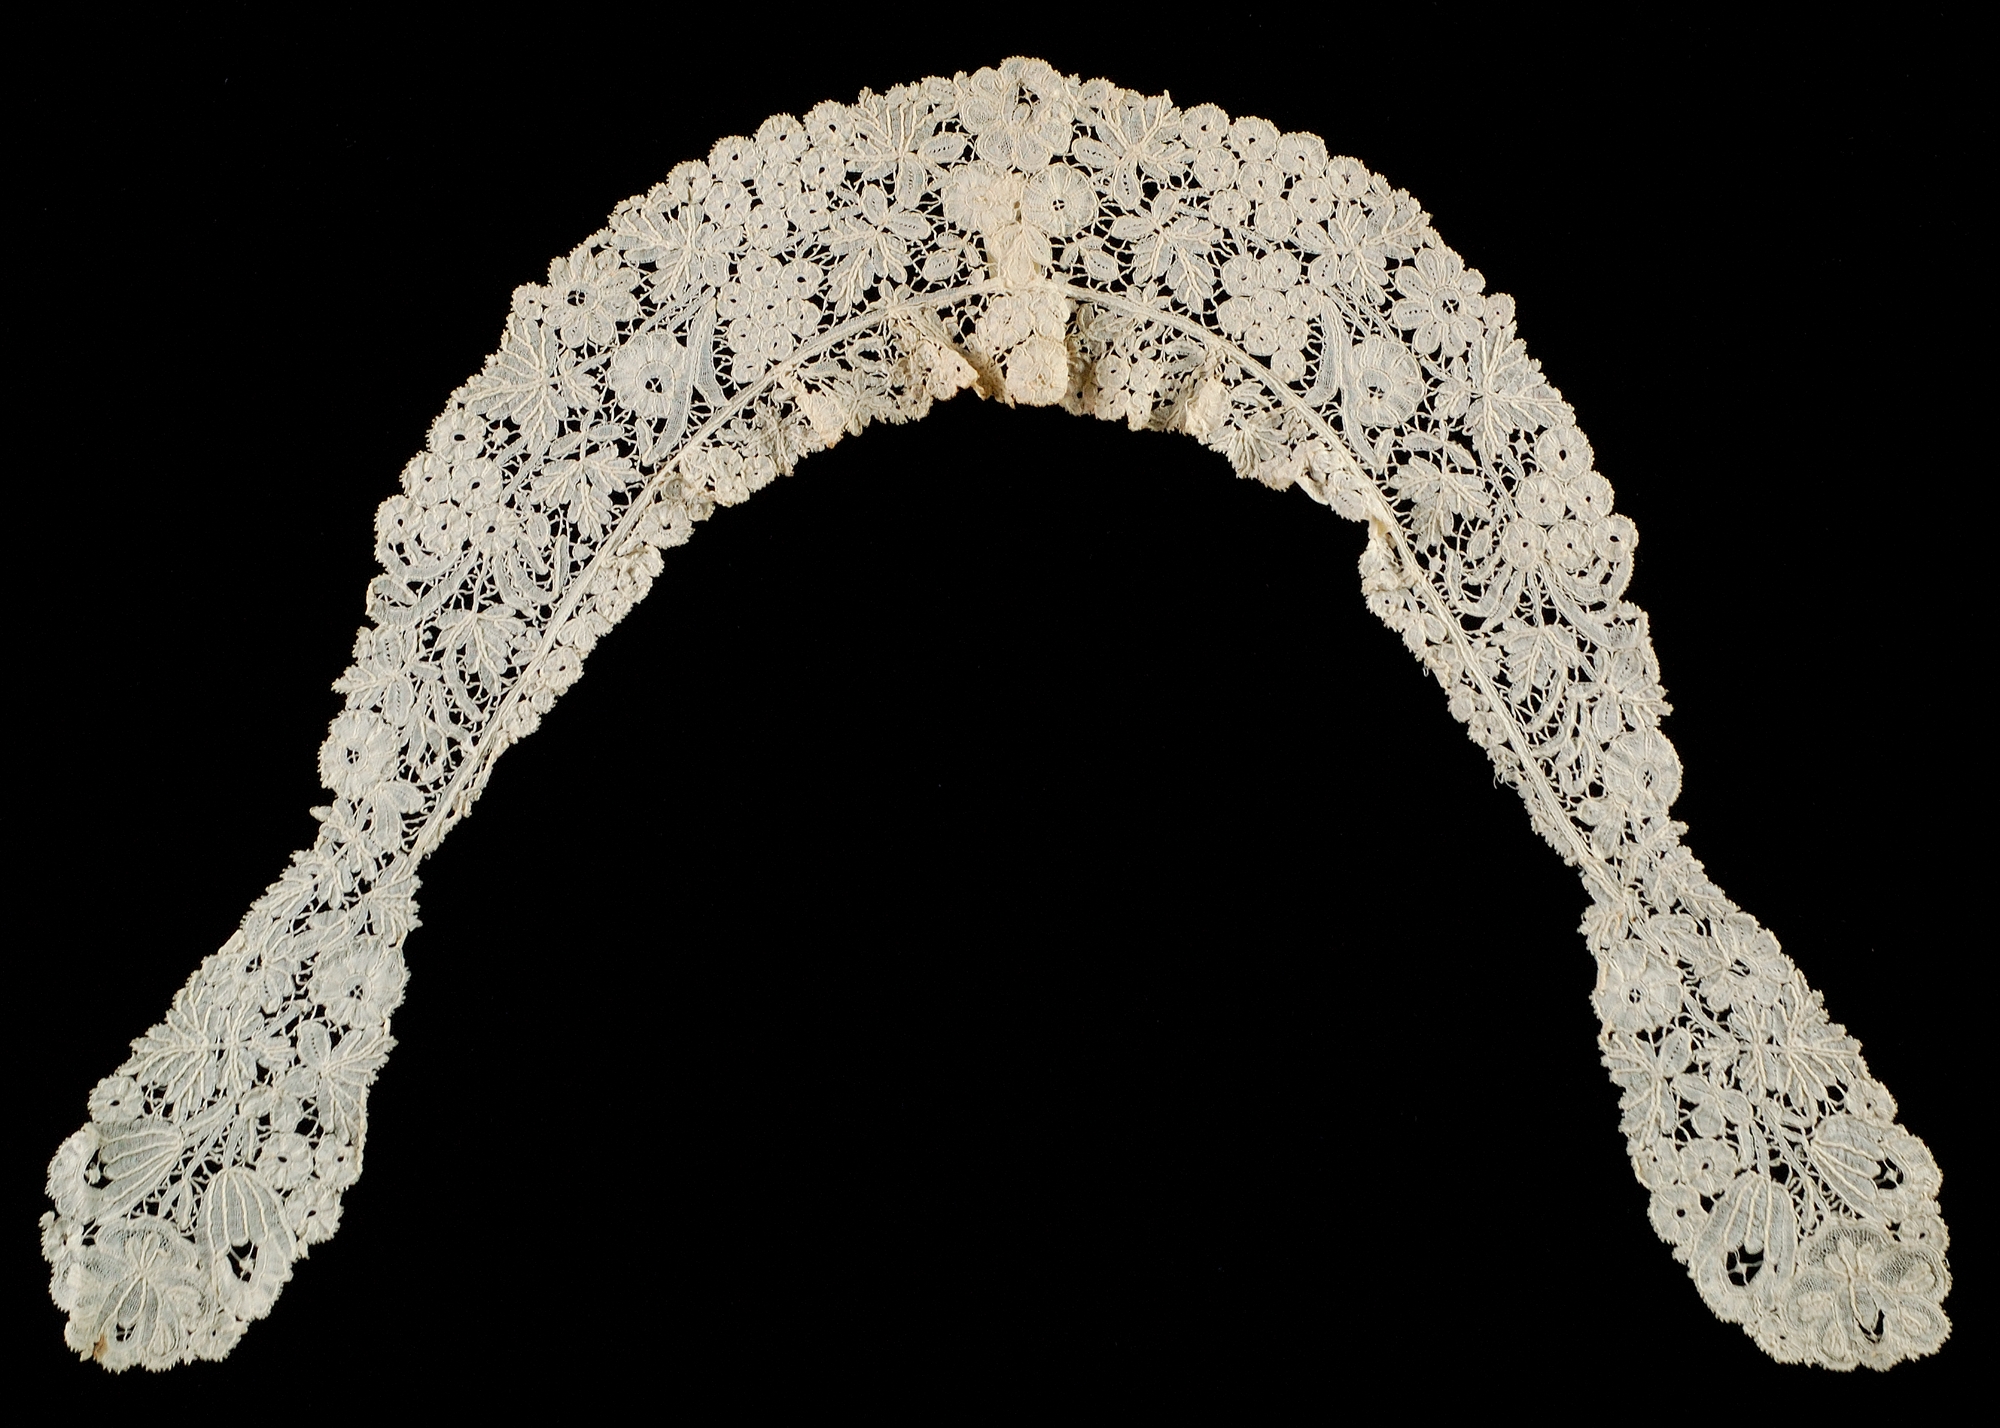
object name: collar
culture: belgian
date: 1850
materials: linen